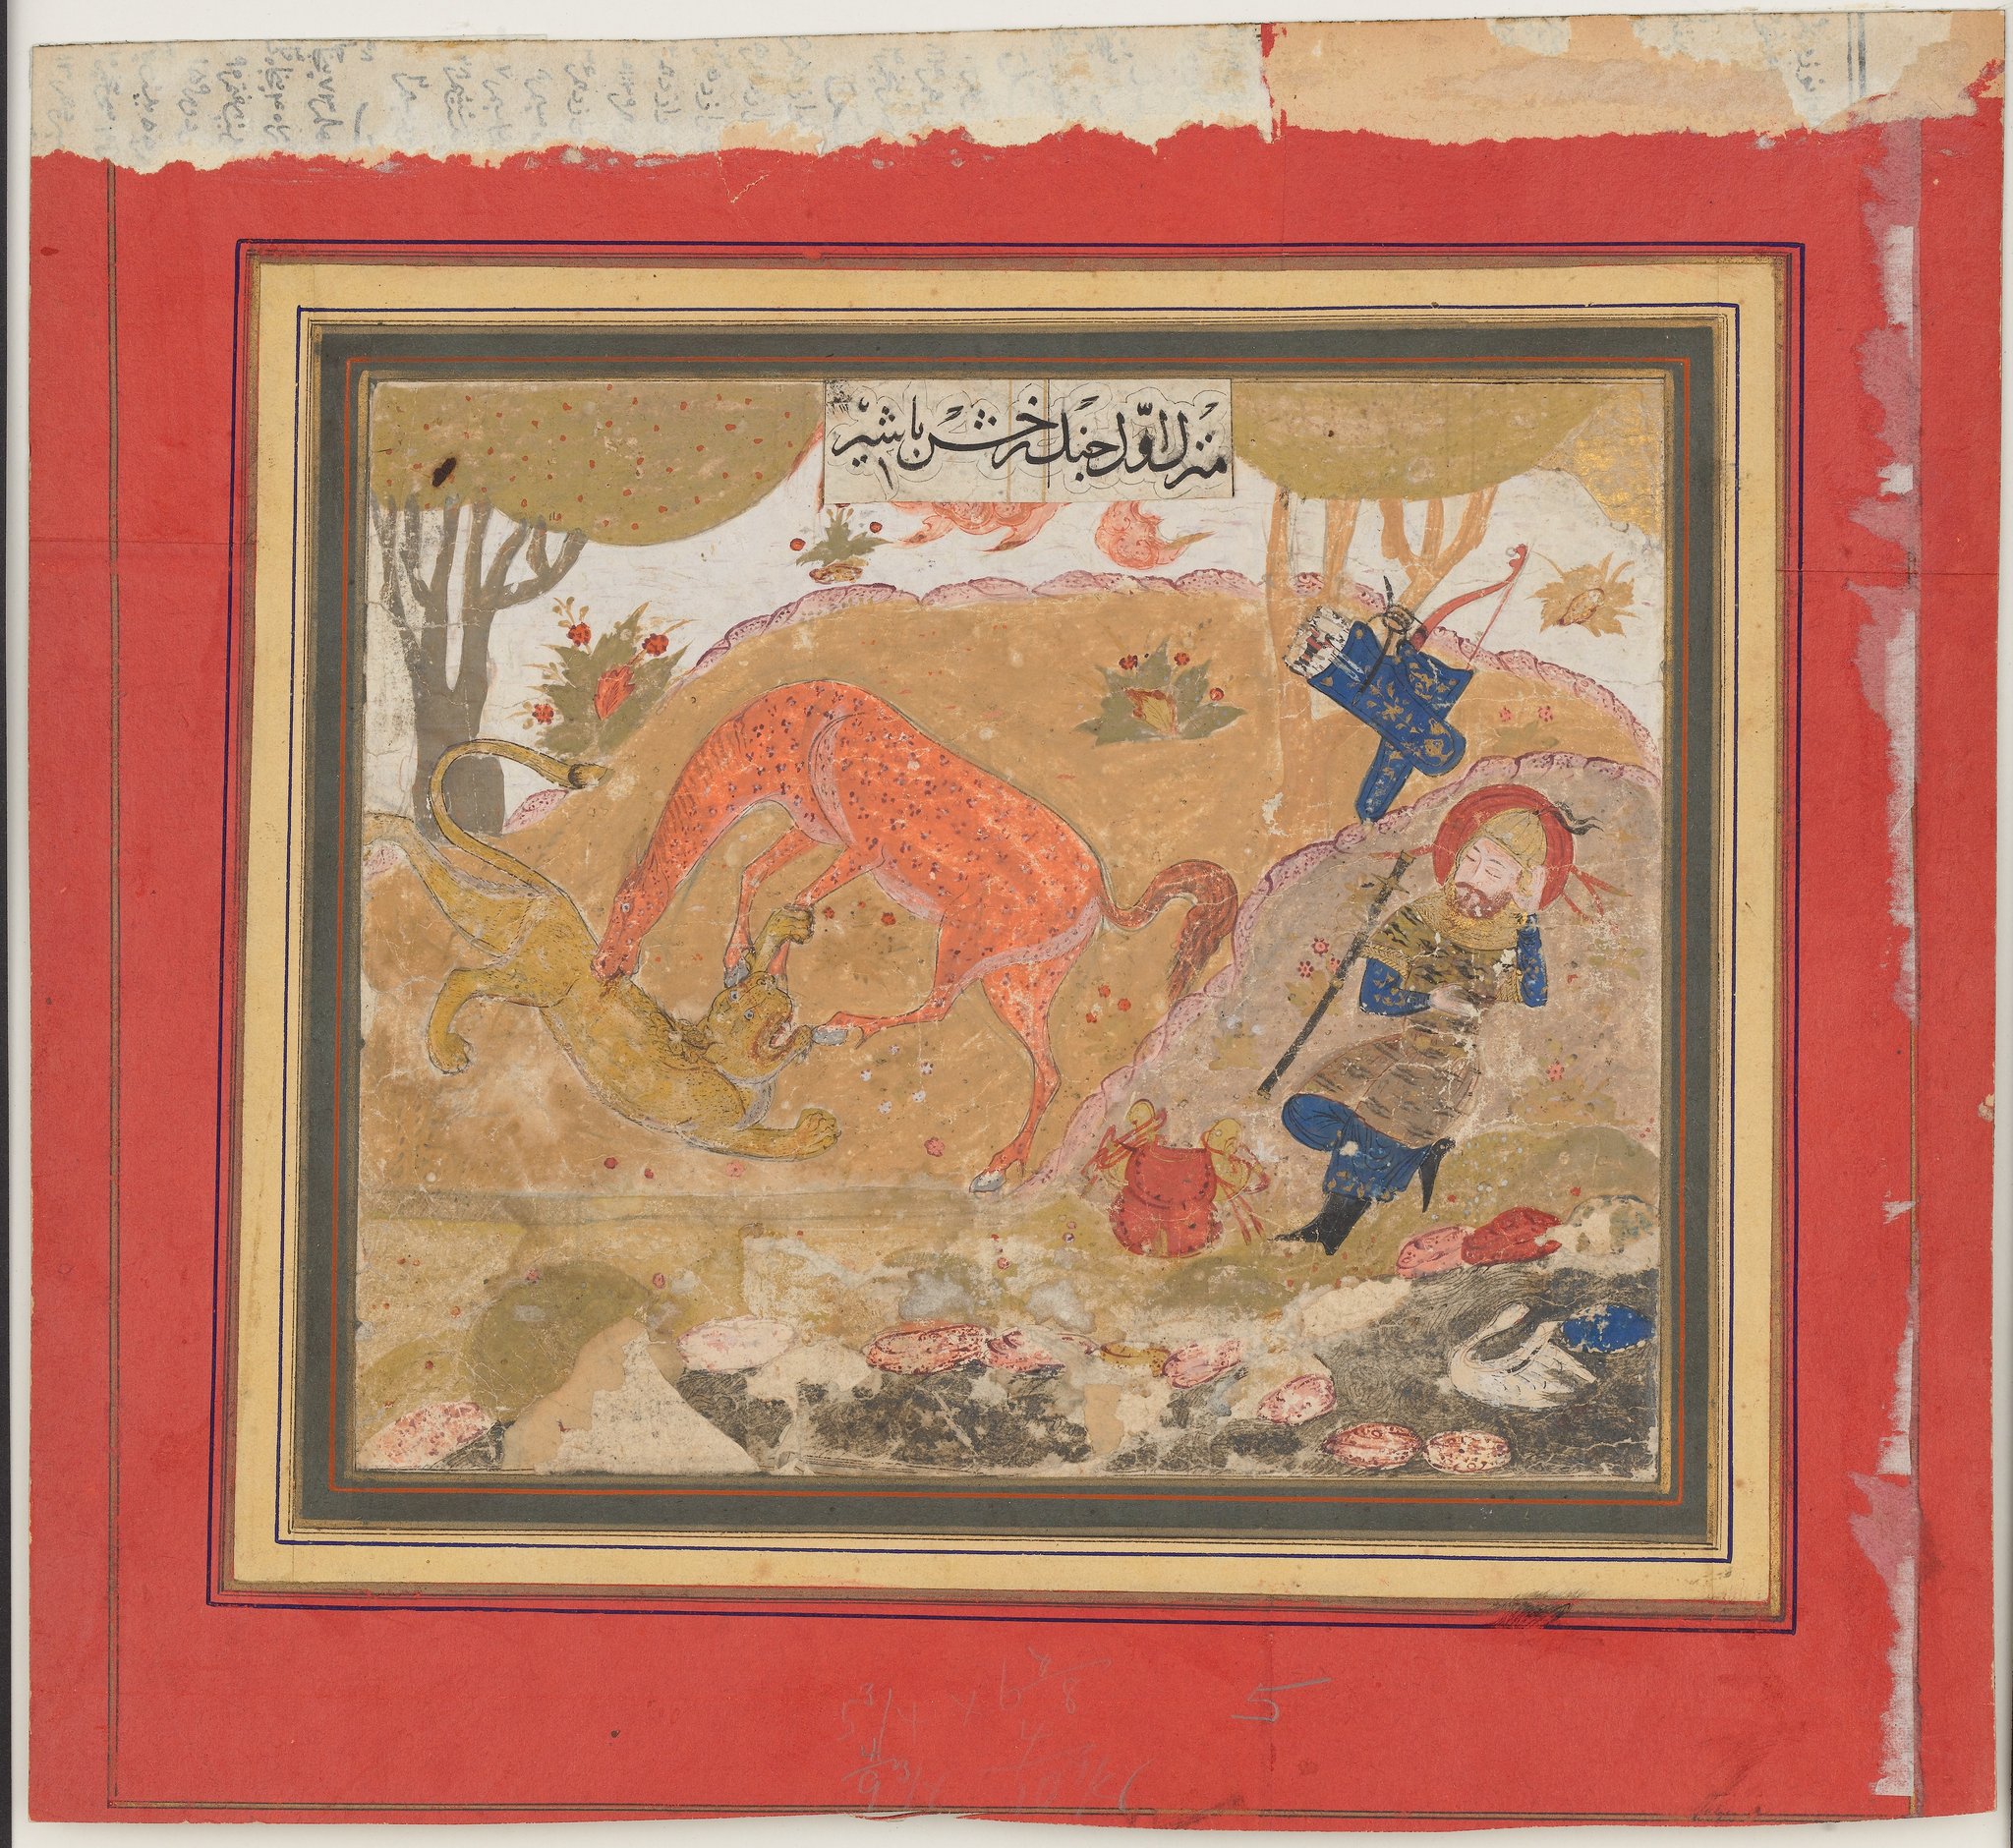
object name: folio from an illustrated manuscript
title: "Rustam's First Course: Rakhsh Kills a Lion", Folio from a Shahnama (Book of Kings)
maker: abu'l qasim firdausi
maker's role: author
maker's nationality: iranian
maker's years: 935-1020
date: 1430-1440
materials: gold, ink, paper, watercolor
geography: india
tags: bow and arrow,men,lions